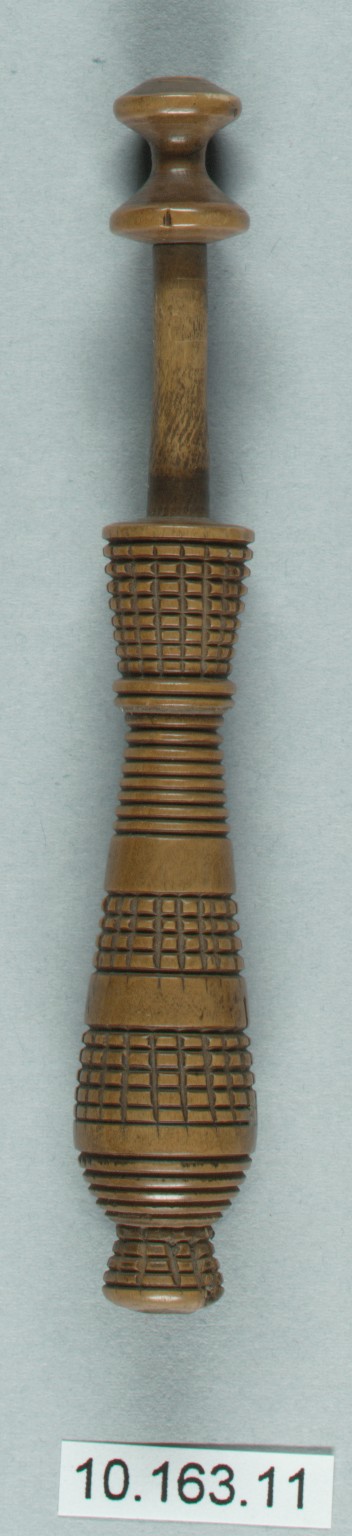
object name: bobbin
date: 1801-1900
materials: wood